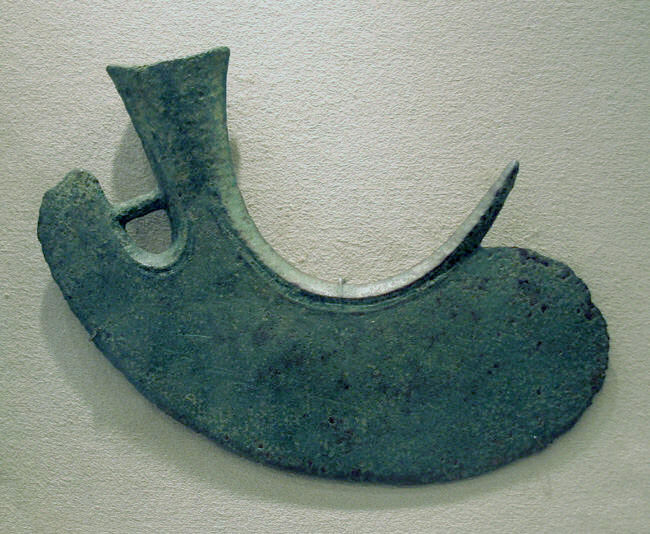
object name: ax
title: Asymmetrical Hafted Ax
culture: indonesian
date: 500 BCE-300 CE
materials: bronze